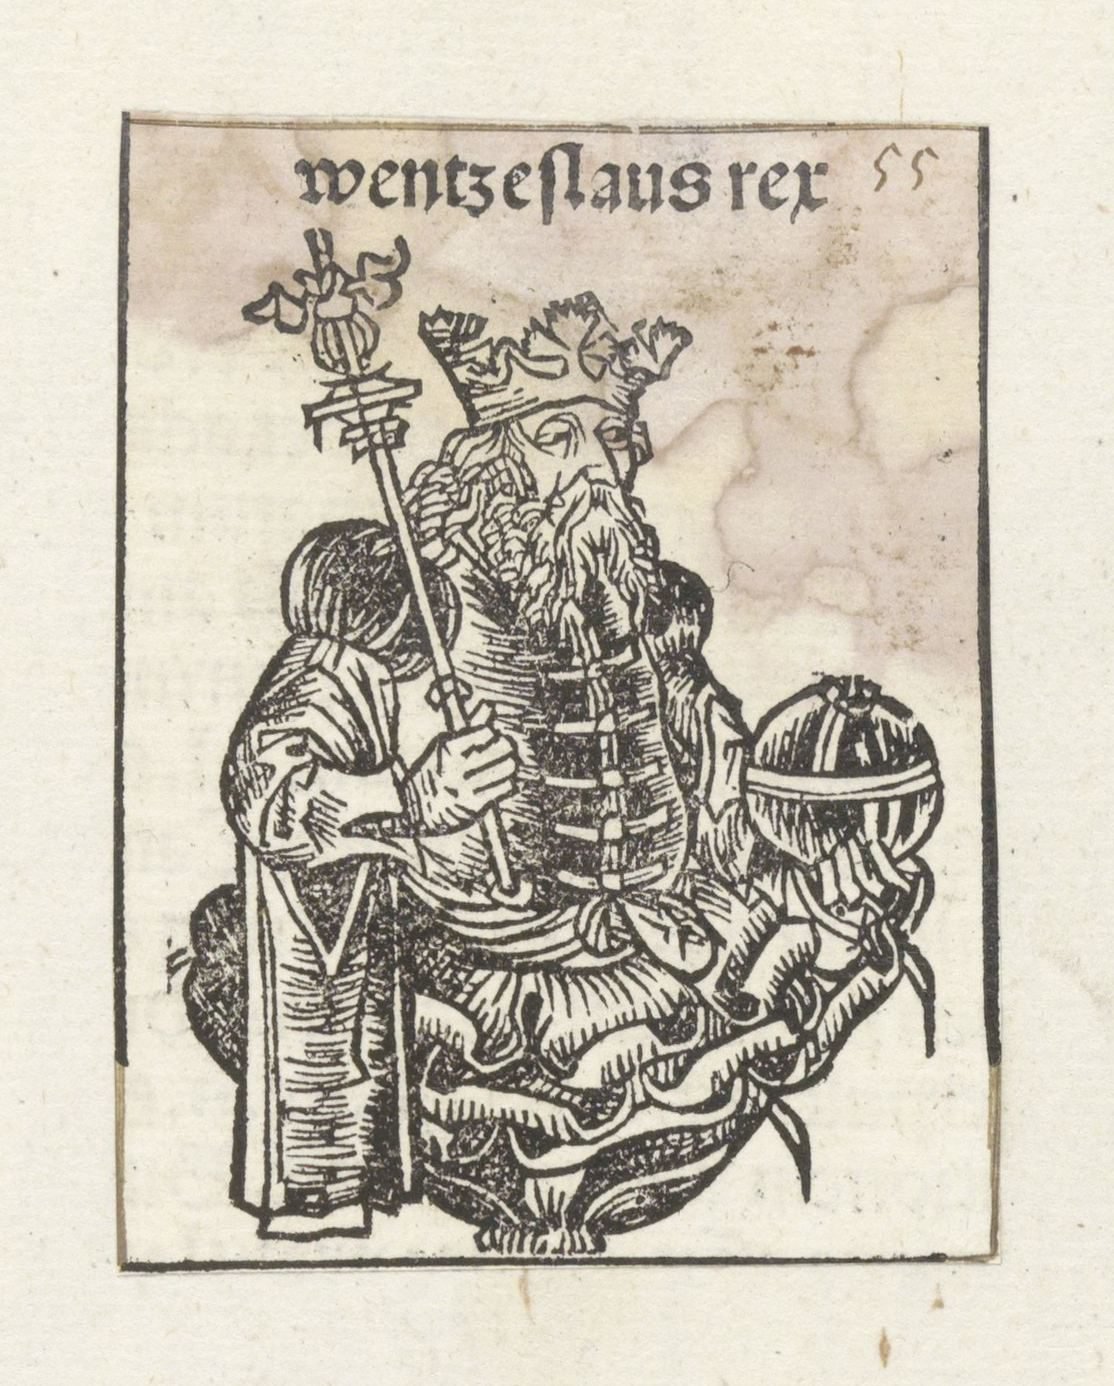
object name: album leaf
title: Liber Chronicarum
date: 1493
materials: paper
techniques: letterpress printing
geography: nuremberg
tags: prague, emperor, king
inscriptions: inscription: ‘55’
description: Een bloemkelk met een koning, naar rechts gekeerd. In zijn handen heeft hij een rijksappel en een scepter. De voorstelling is onderdeel van de opeenvolging keizers in de Liber Chronicarum. De tekst identificeert de man als Wenceslaus I. De prent maakt deel uit van een album.